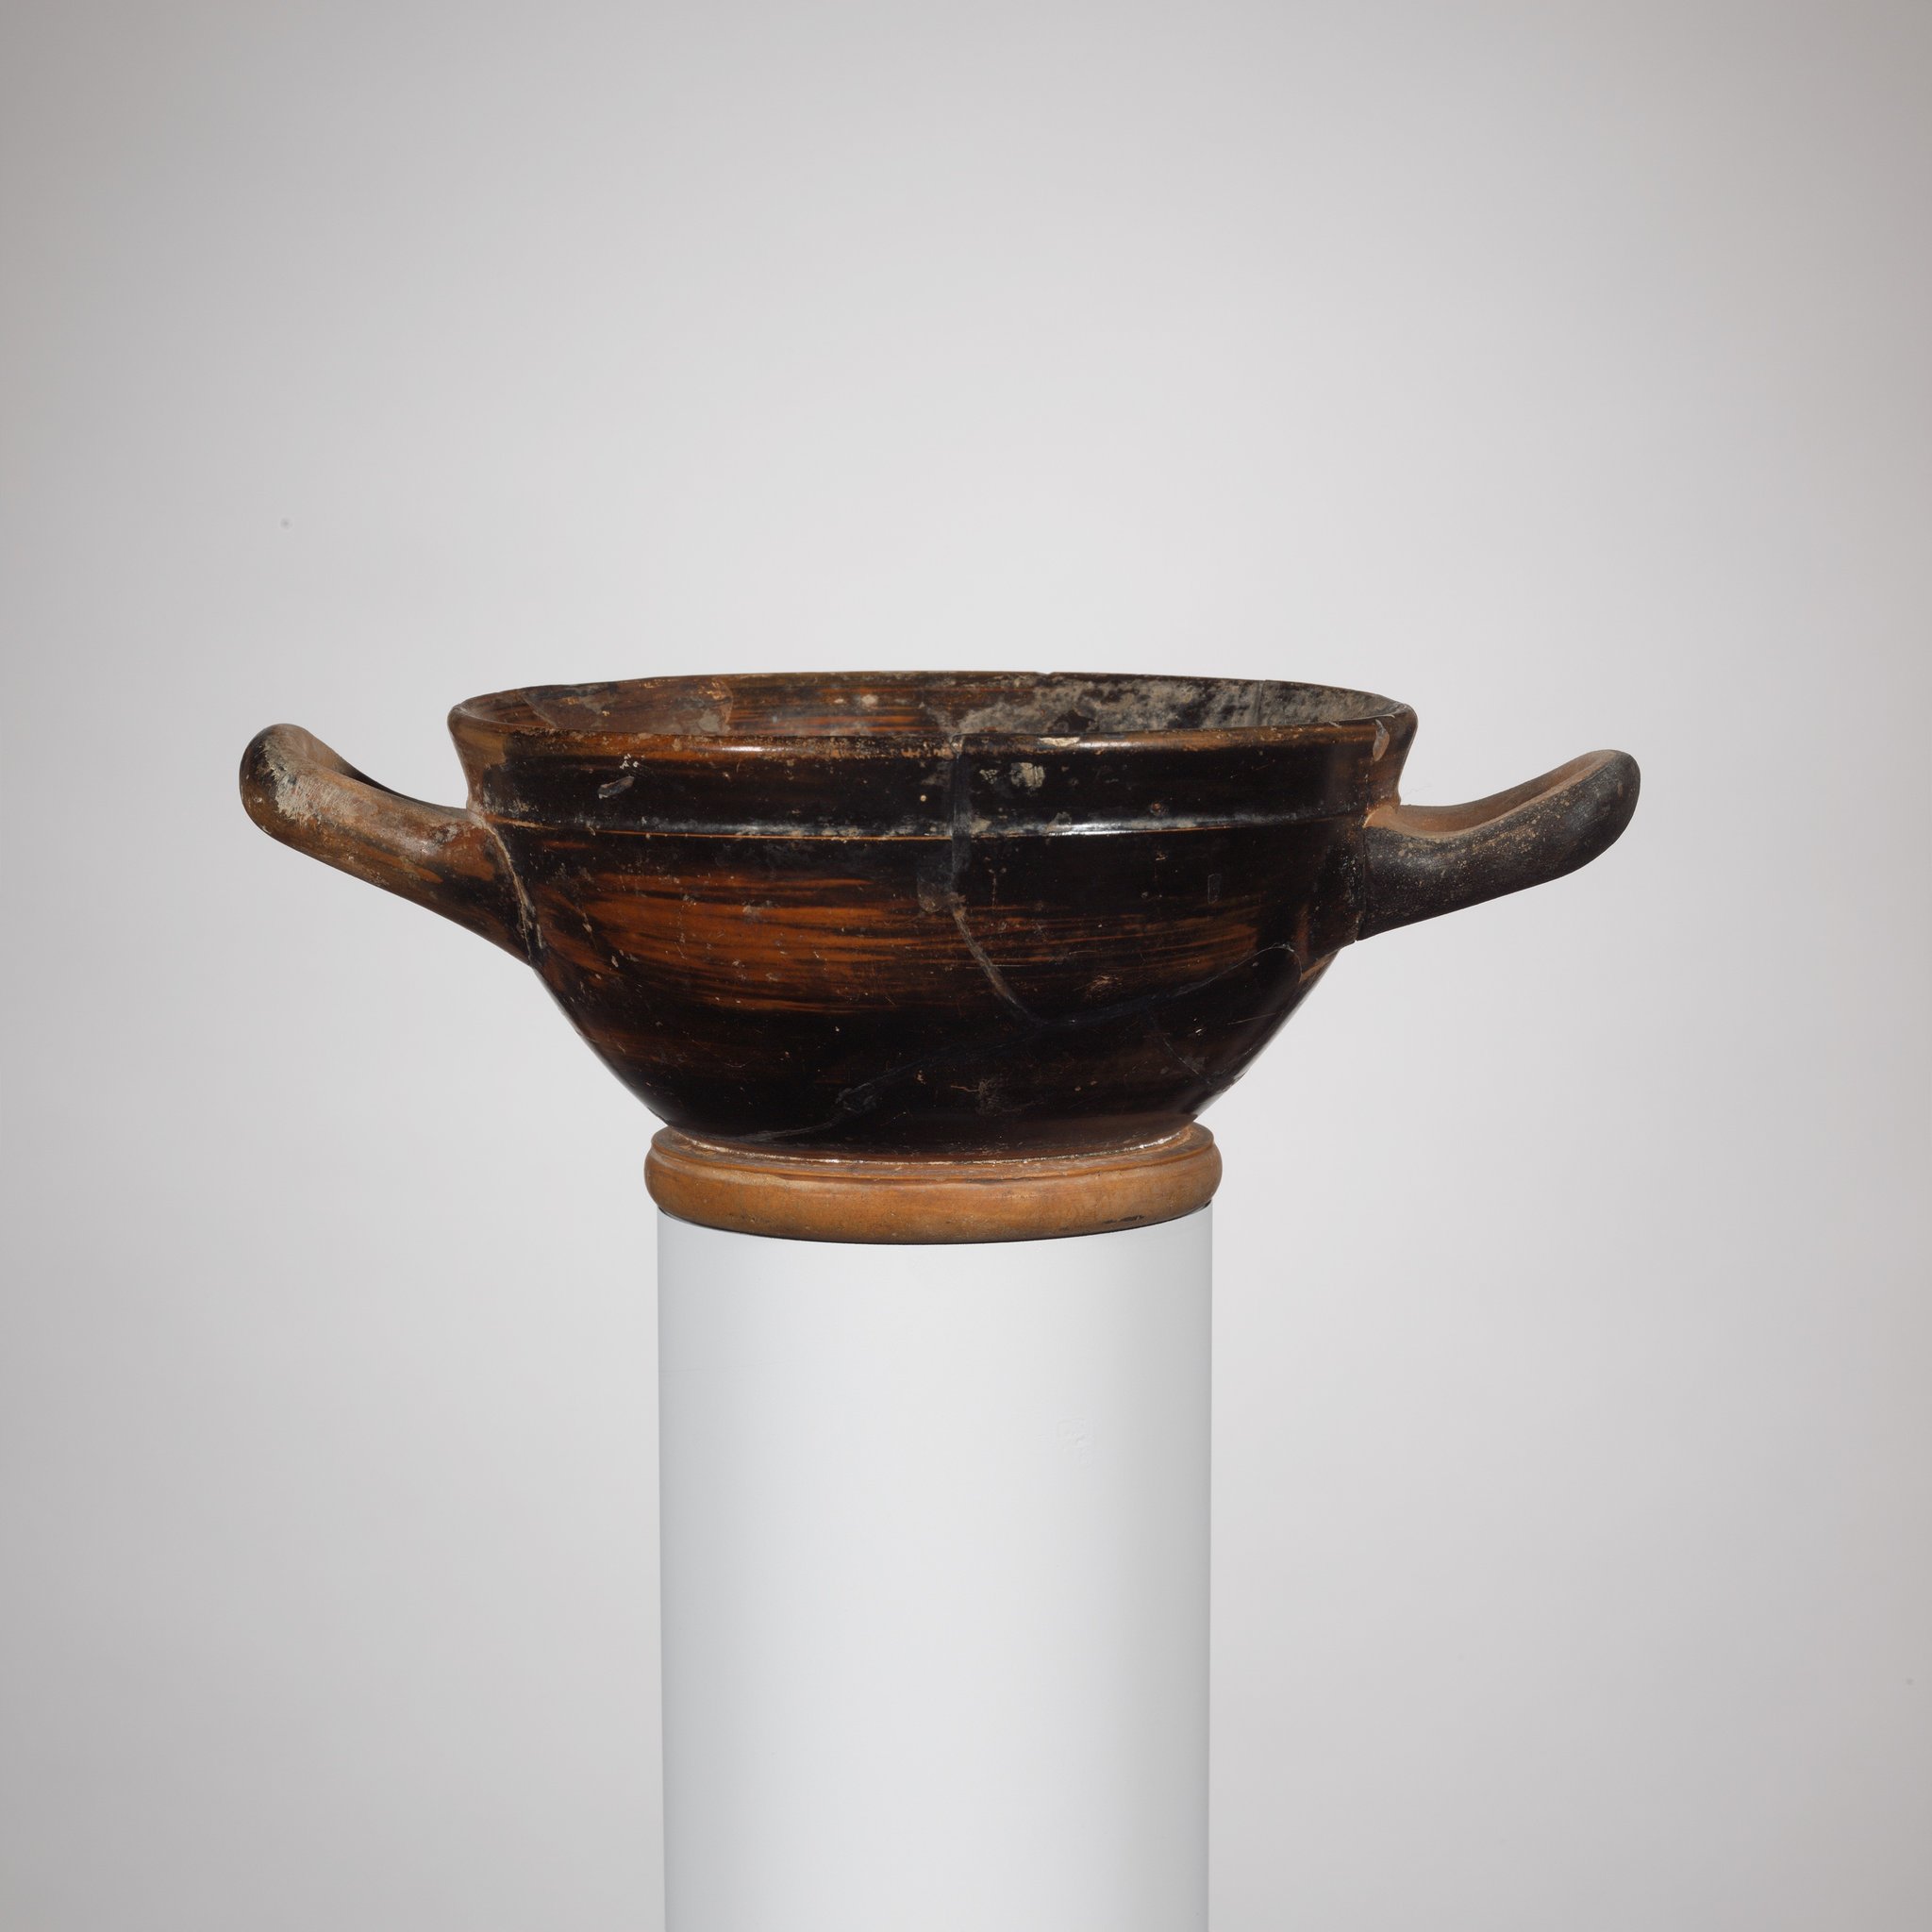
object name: skyphos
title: Terracotta skyphos (deep drinking cup)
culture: greek, attic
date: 450-400 BCE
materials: terracotta